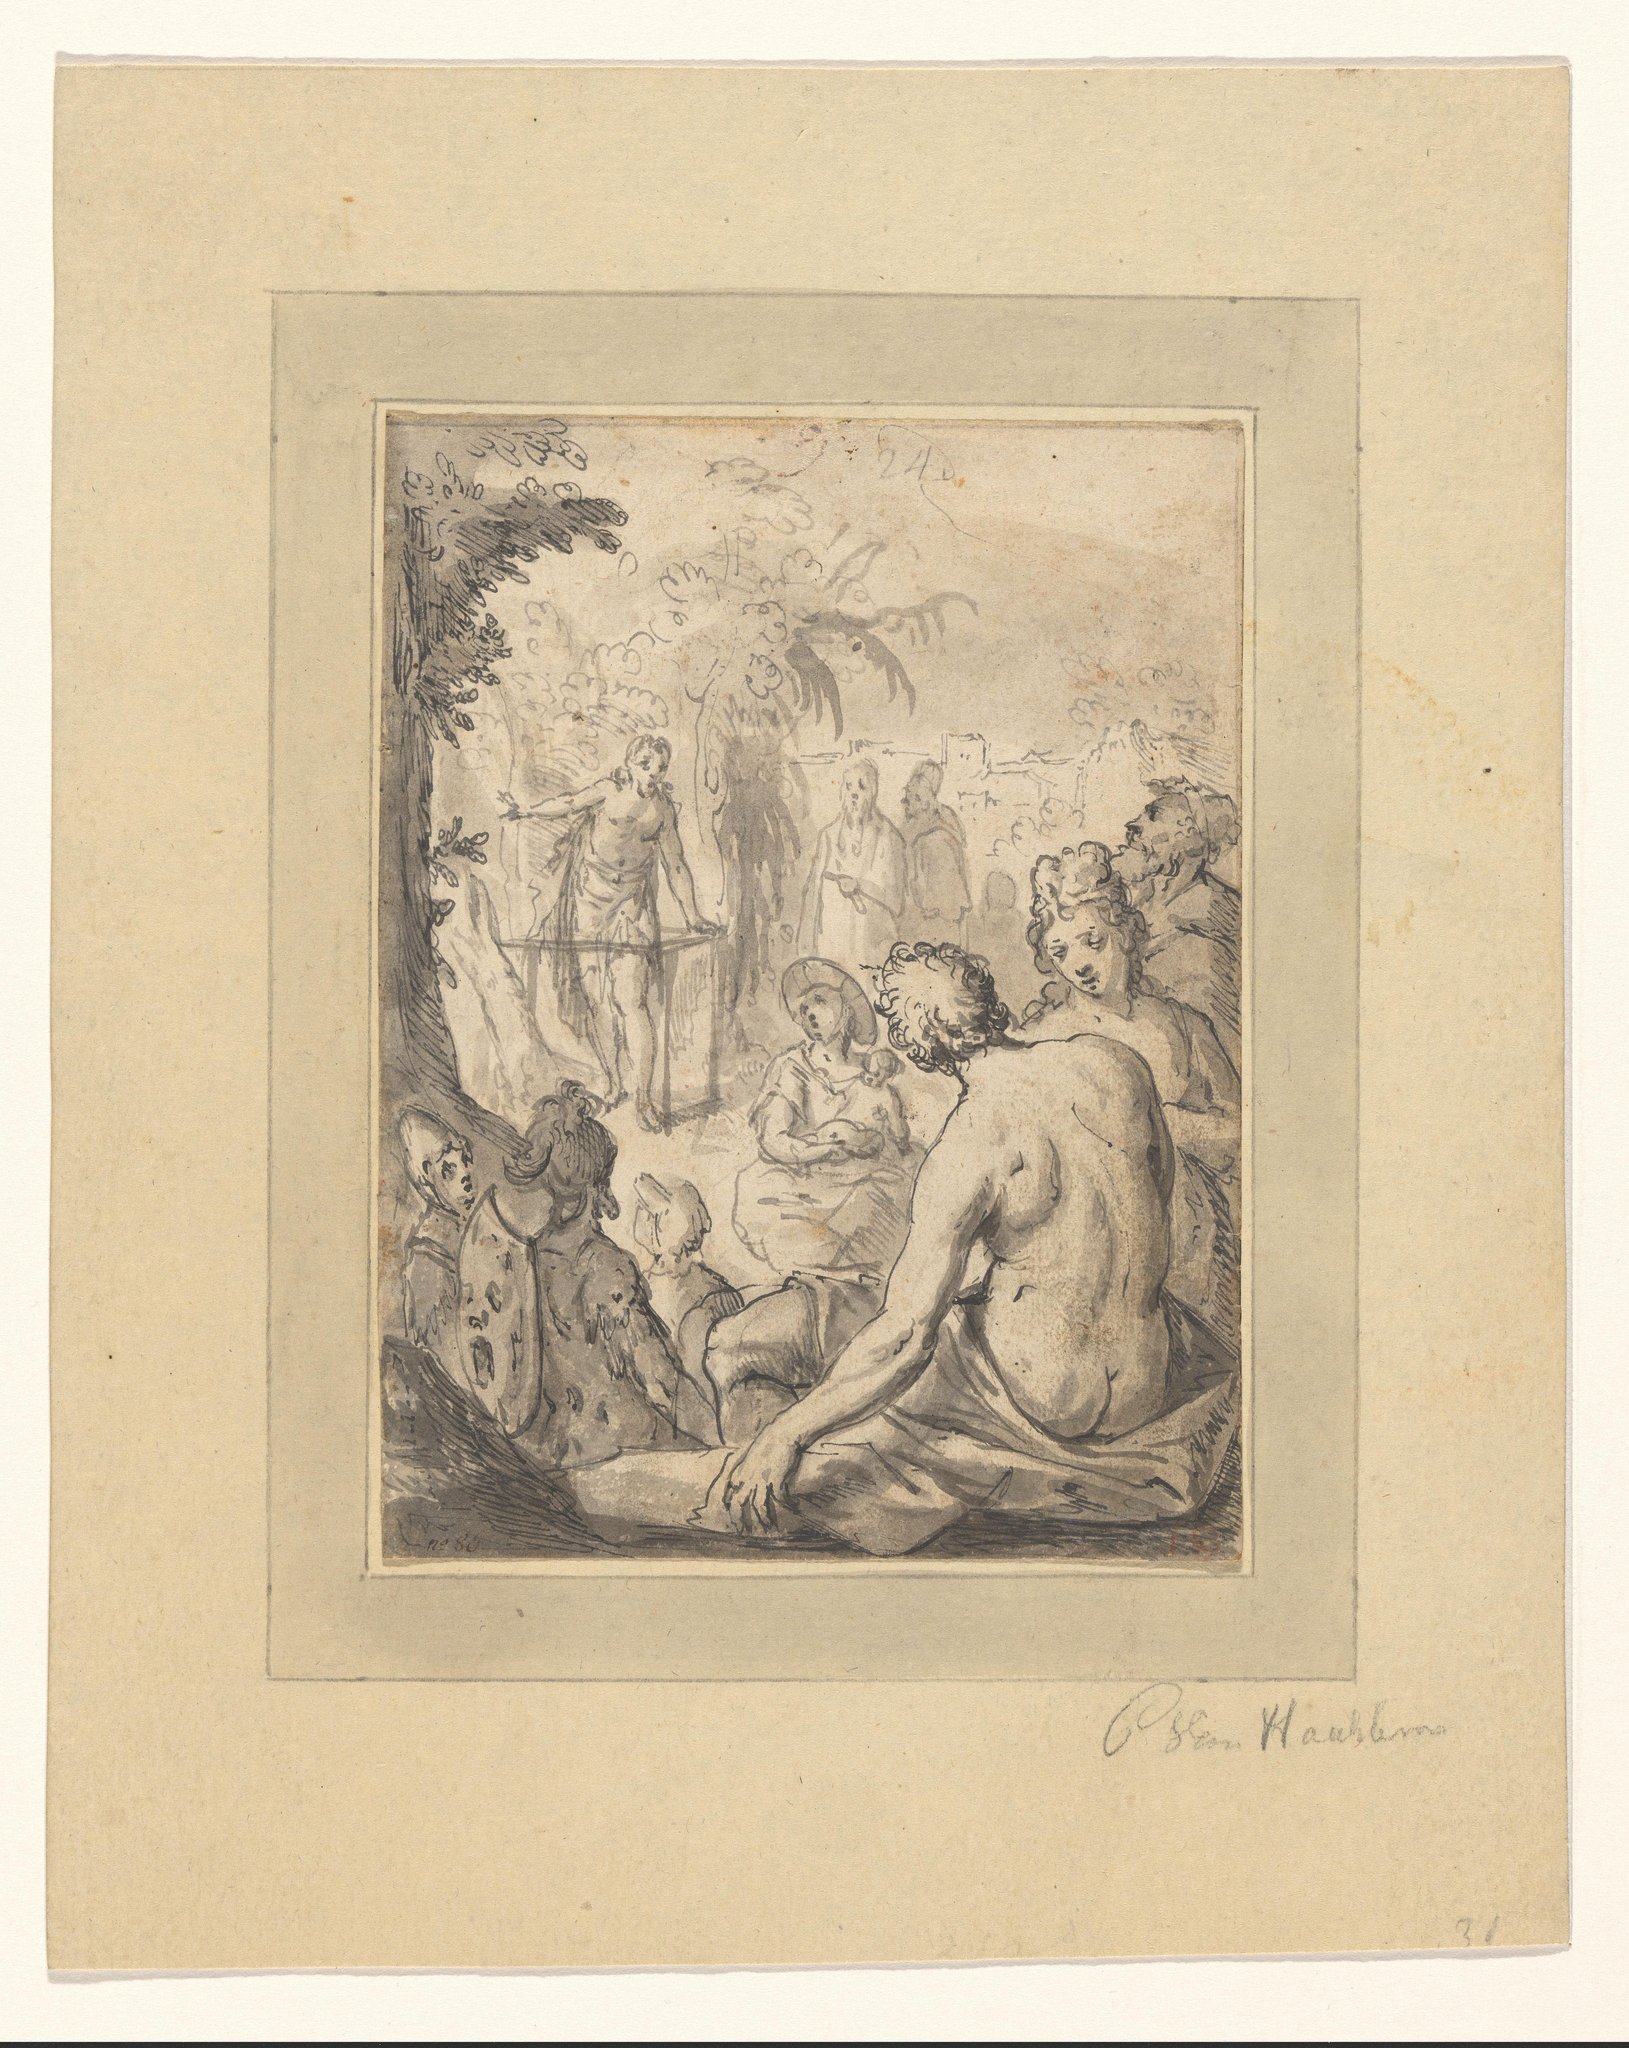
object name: drawing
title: Prediking van Johannes de Doper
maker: karel van mander (i)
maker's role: draughtsman, painter, print maker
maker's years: 1548-1606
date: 1500-1599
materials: ink, paper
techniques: brush, pen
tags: john the baptist preaching (perhaps christ among the bystanders)